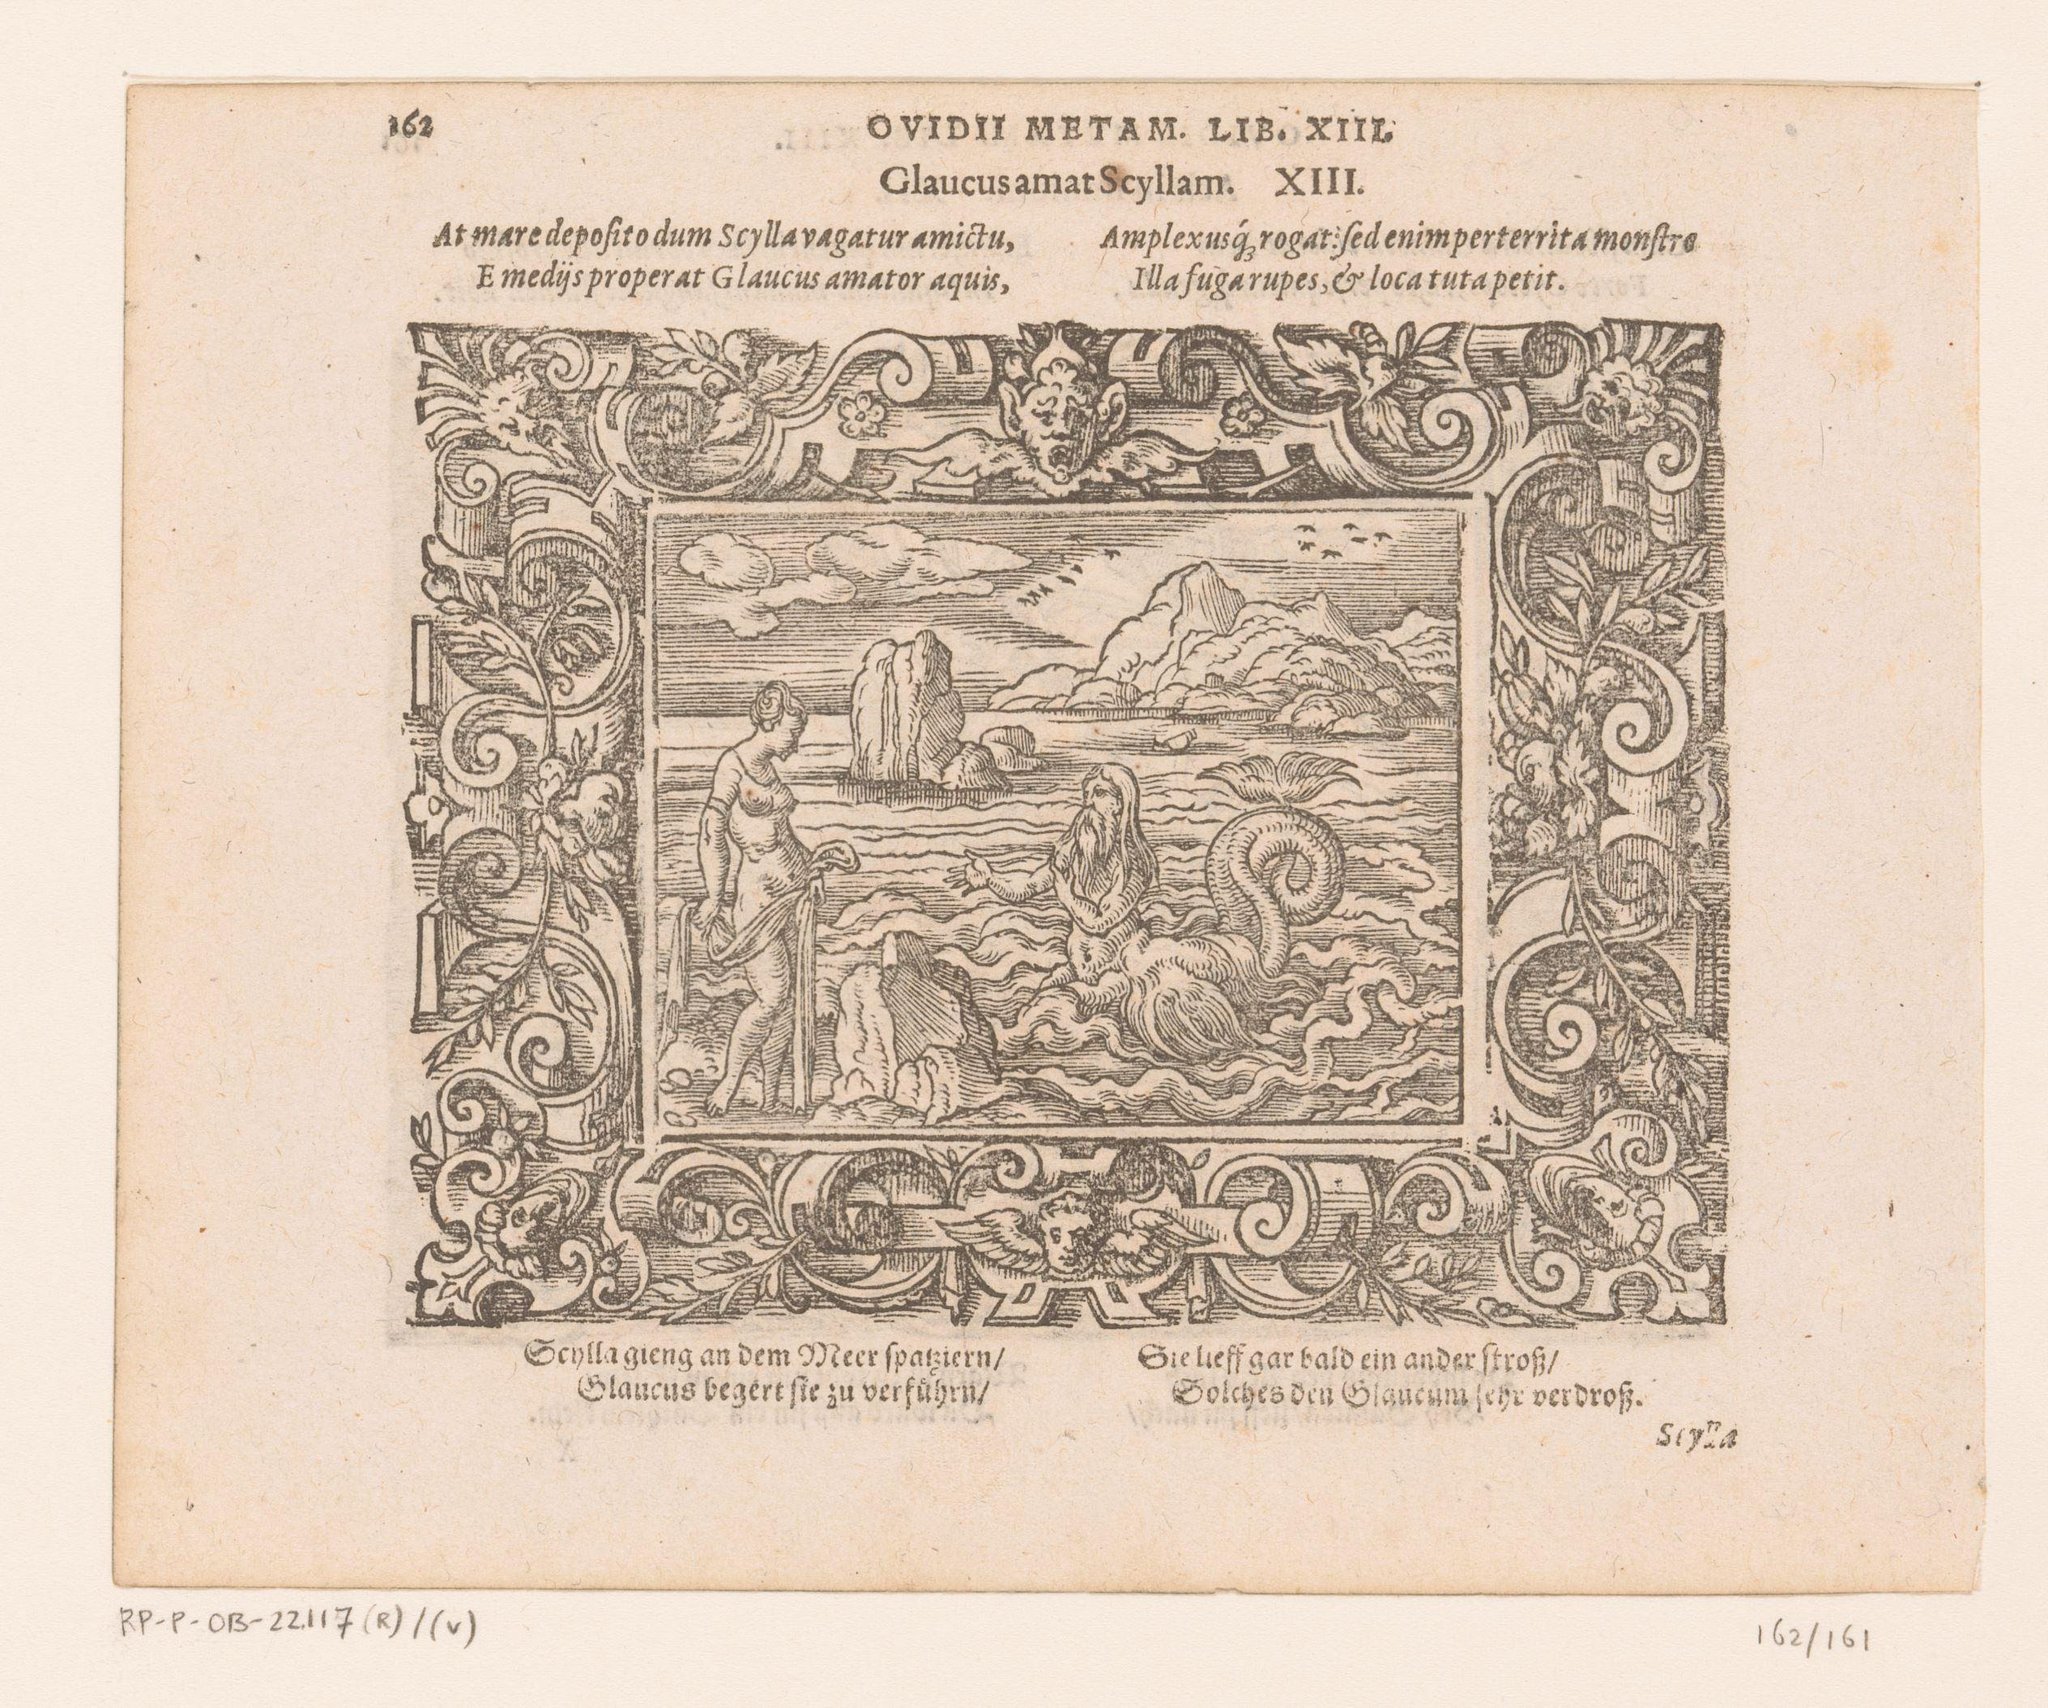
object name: book illustration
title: Glaucus en Scylla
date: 1569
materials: paper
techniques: letterpress printing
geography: frankfurt am main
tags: scylla fleeing from glaucus, scrollwork, strapwork ~ ornament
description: Illustratie bij de Metamorfosen van Ovidius, afkomstig uit de publicatie: Posthius, Johannes. Tetrasticha in Ovidii metam. Frankfurt am Main: Georg Rab en Sigmund Feyerabend en erven Weigand Han, 1569. De voorstellingen en ornamentranden van deze boekillustraties zijn van twee aparte blokken gedrukt. Beide werden afzonderlijk van elkaar ook gebruikt voor andere publicaties, en de ornamentranden werden eveneens binnen deze publicatie meerdere keren gebruikt.